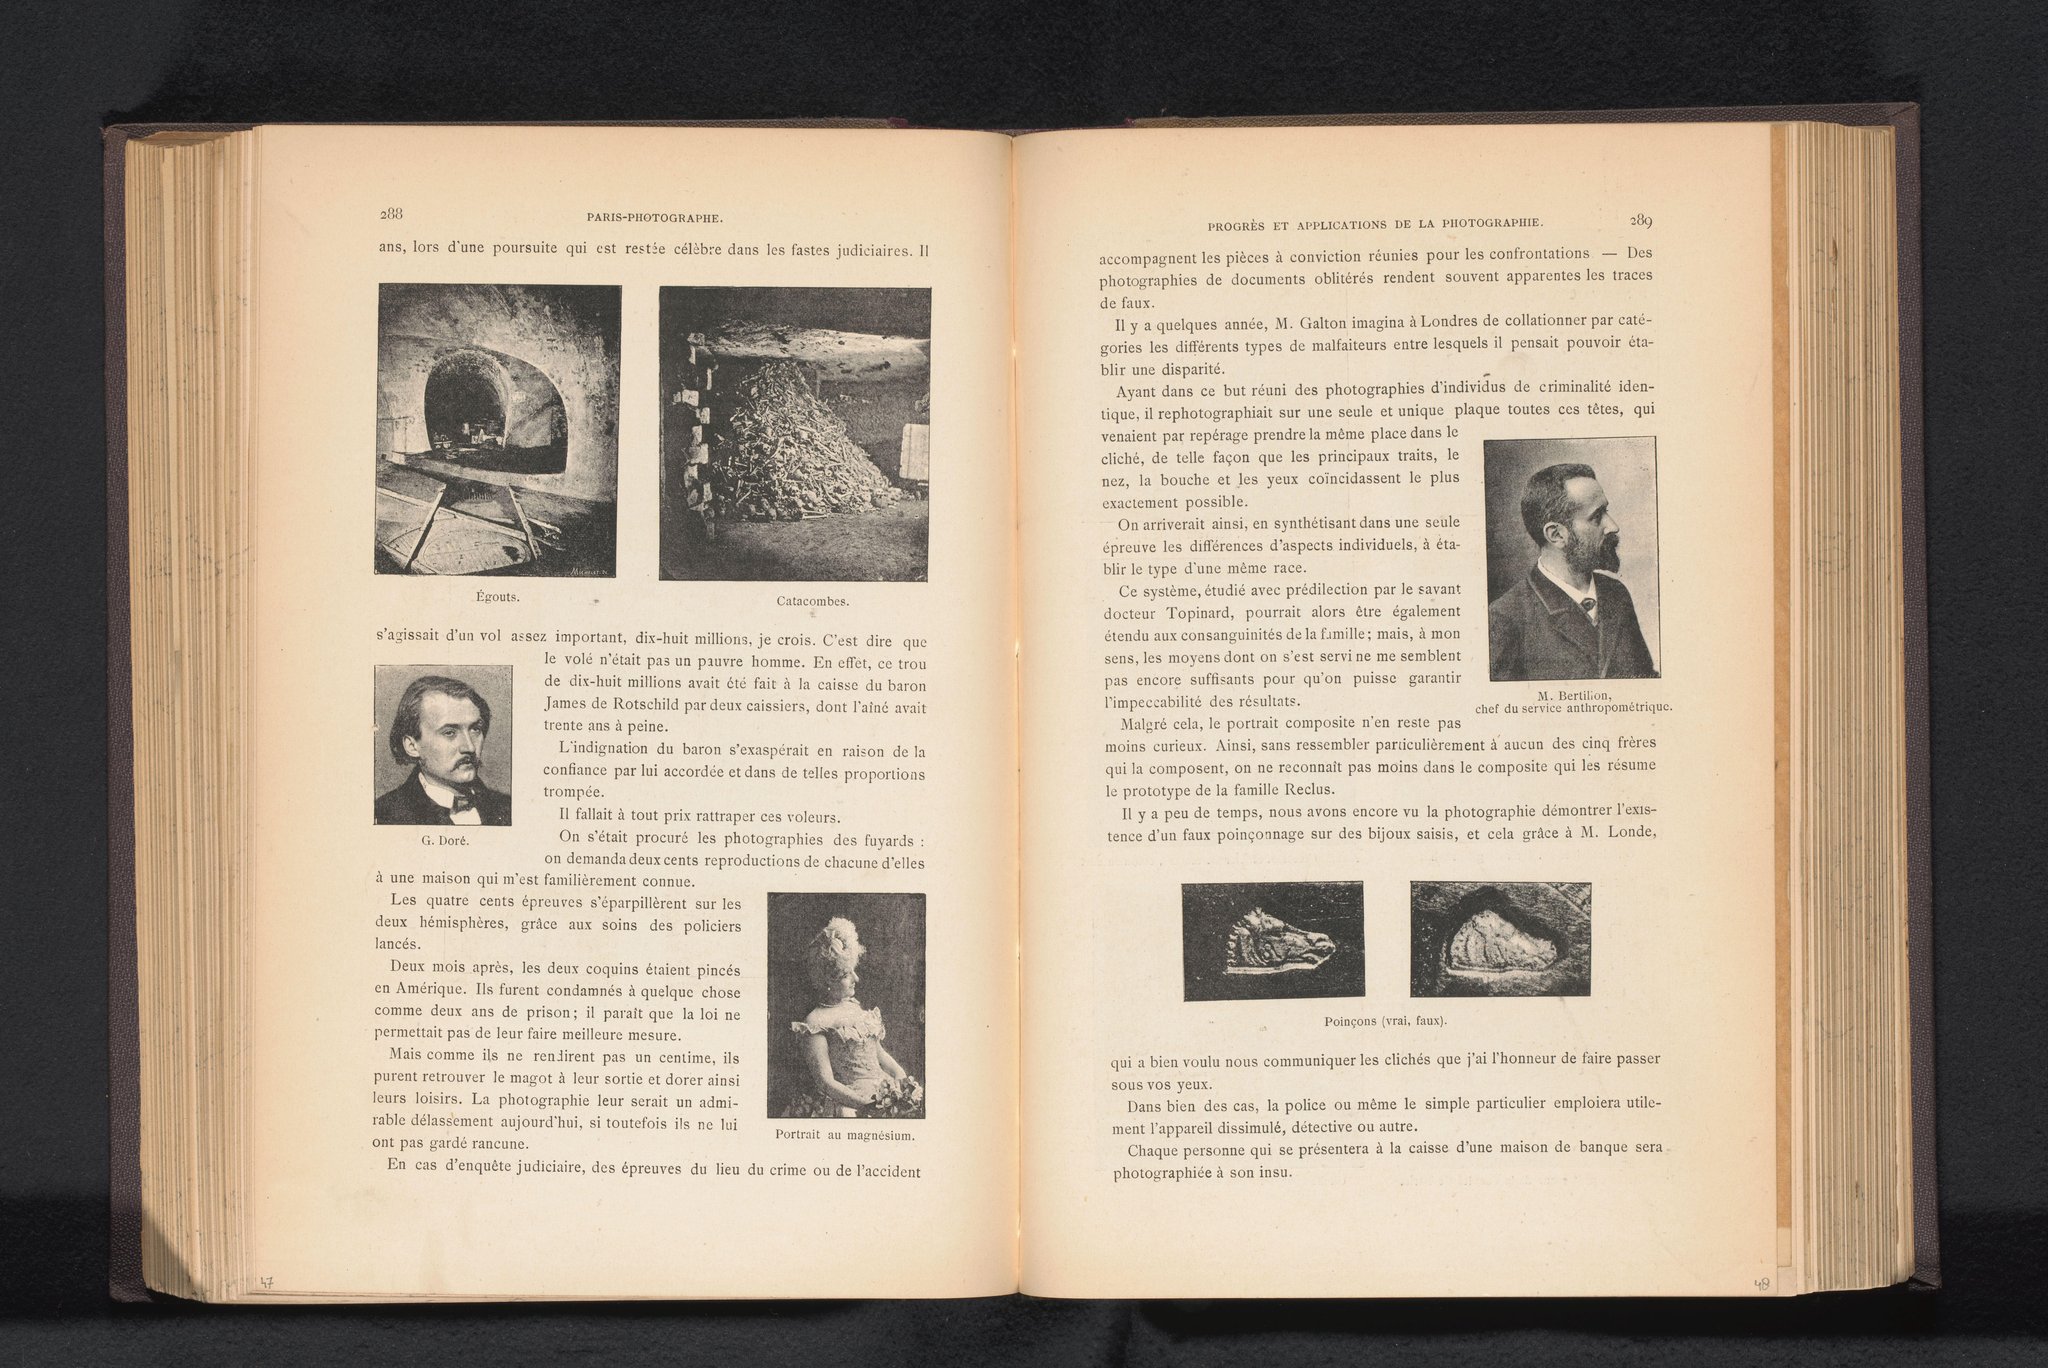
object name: page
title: Portret van Alphonse Bertillon en twee opnamen van een stempel van een paard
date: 1882-1892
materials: paper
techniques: autotype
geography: france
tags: alphonse bertillon, adult man, seal, stamp